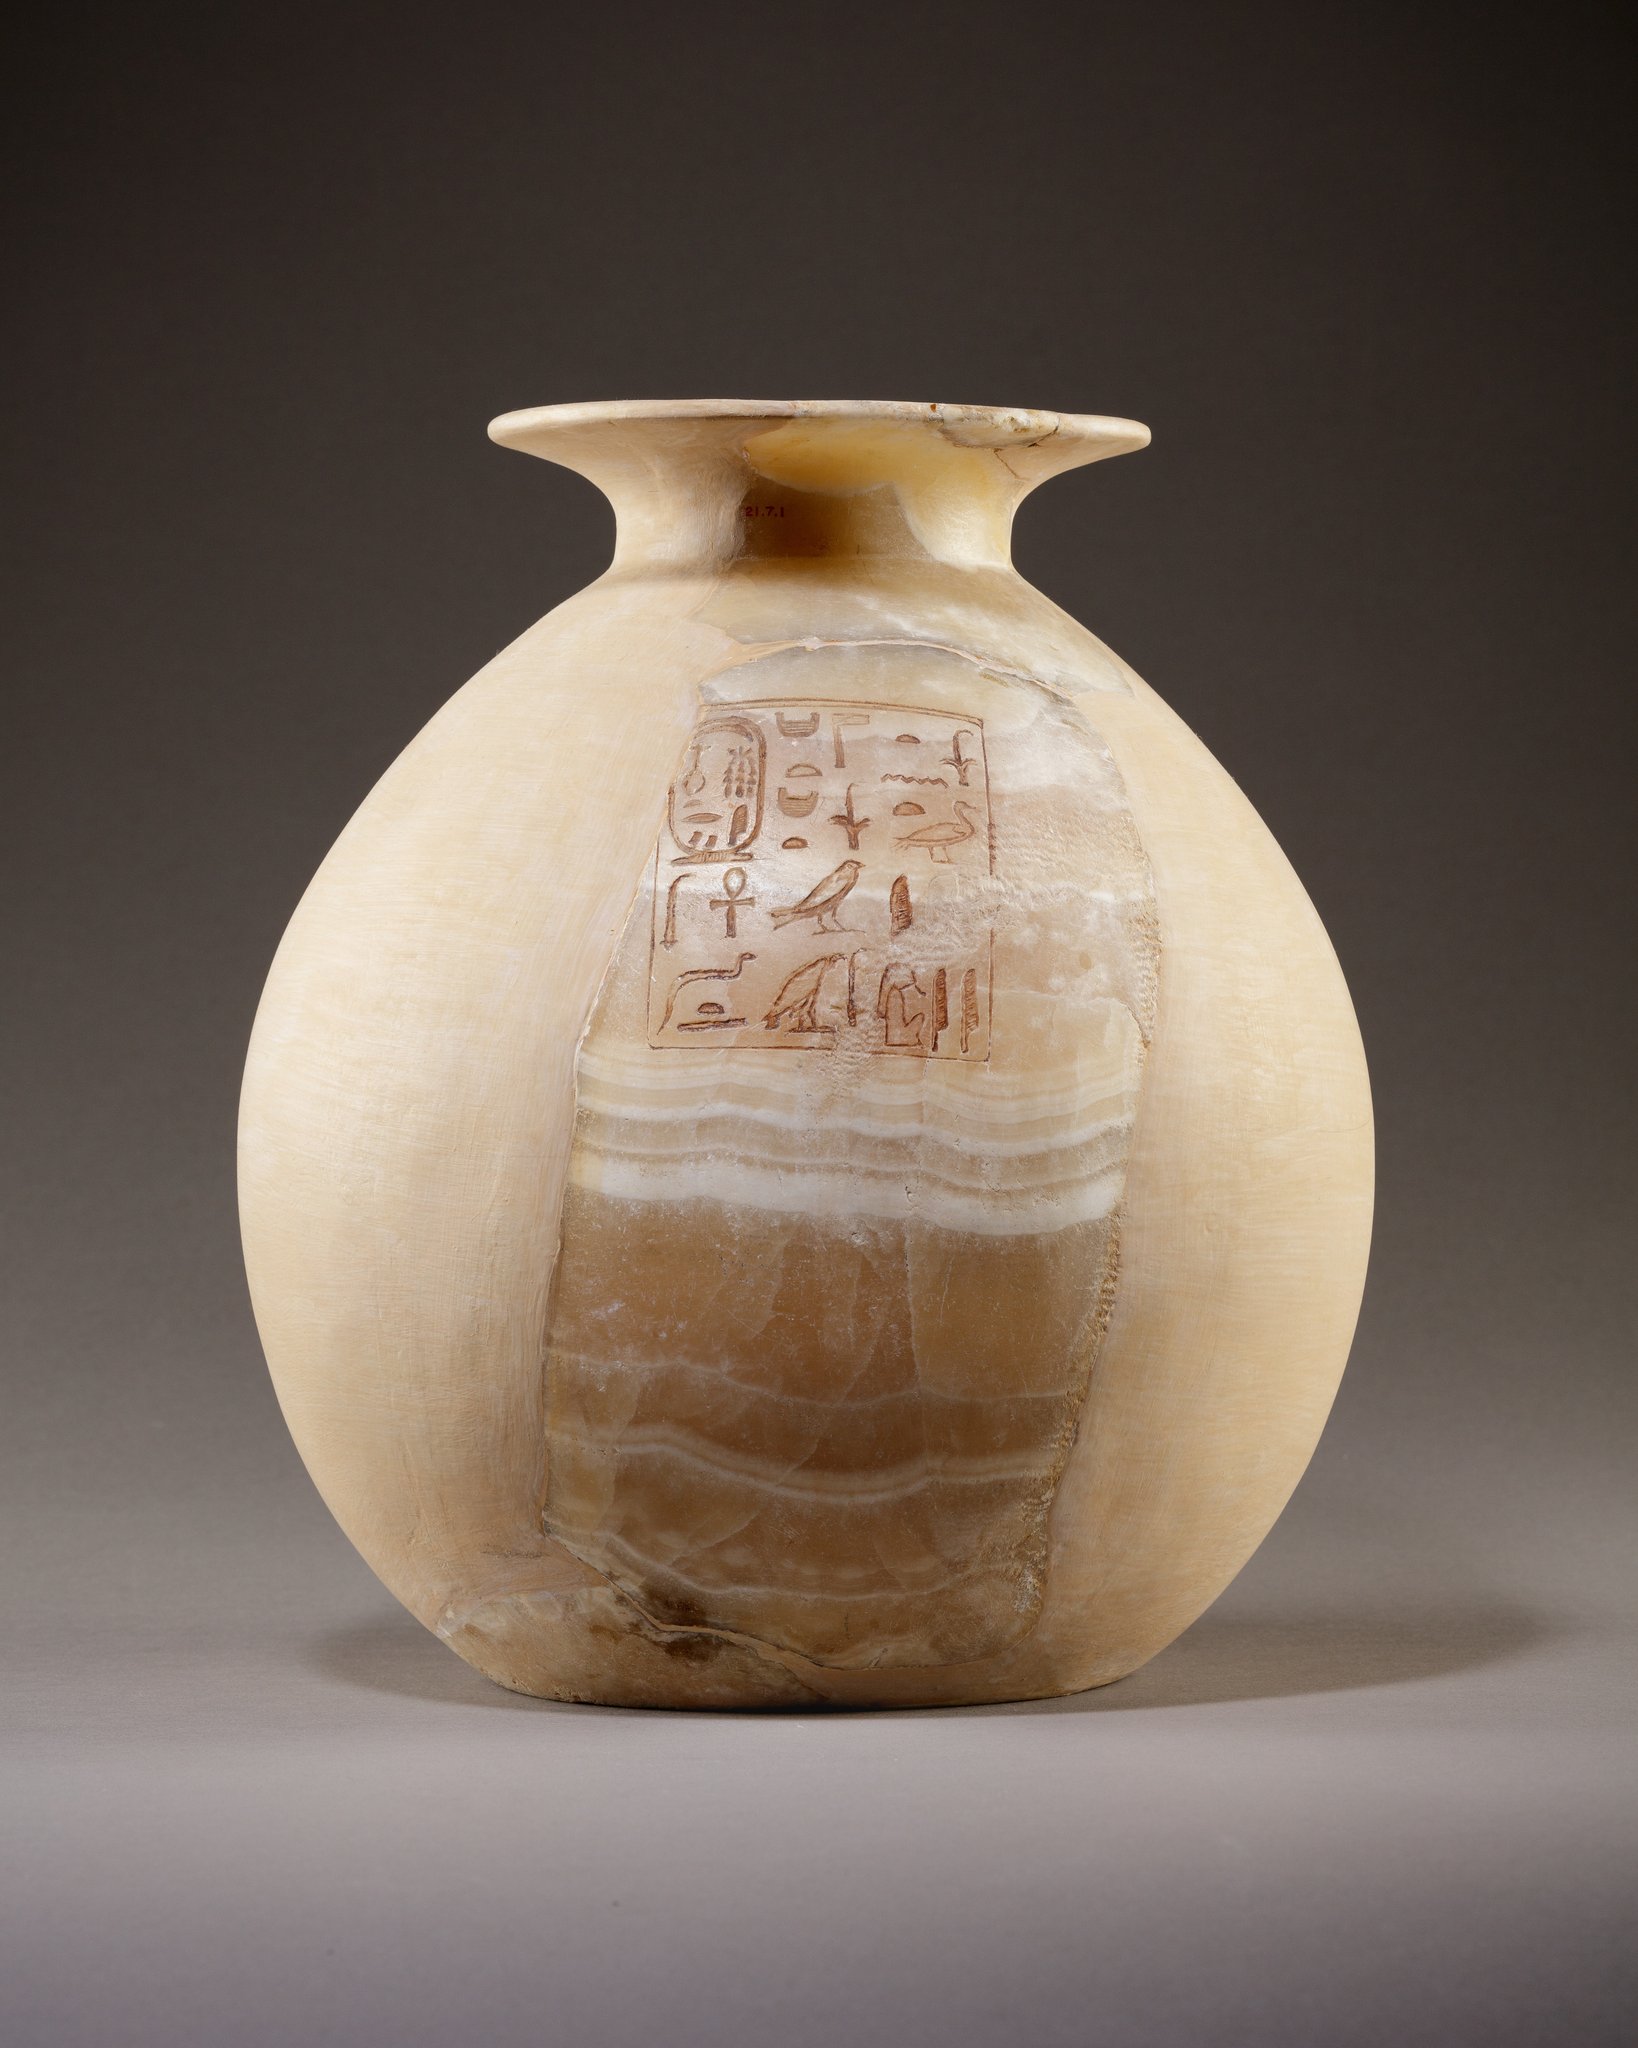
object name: jar, ahmose nefertari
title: Jar of Ahmose-Nefertari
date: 1525-1504 BCE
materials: stone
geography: egypt